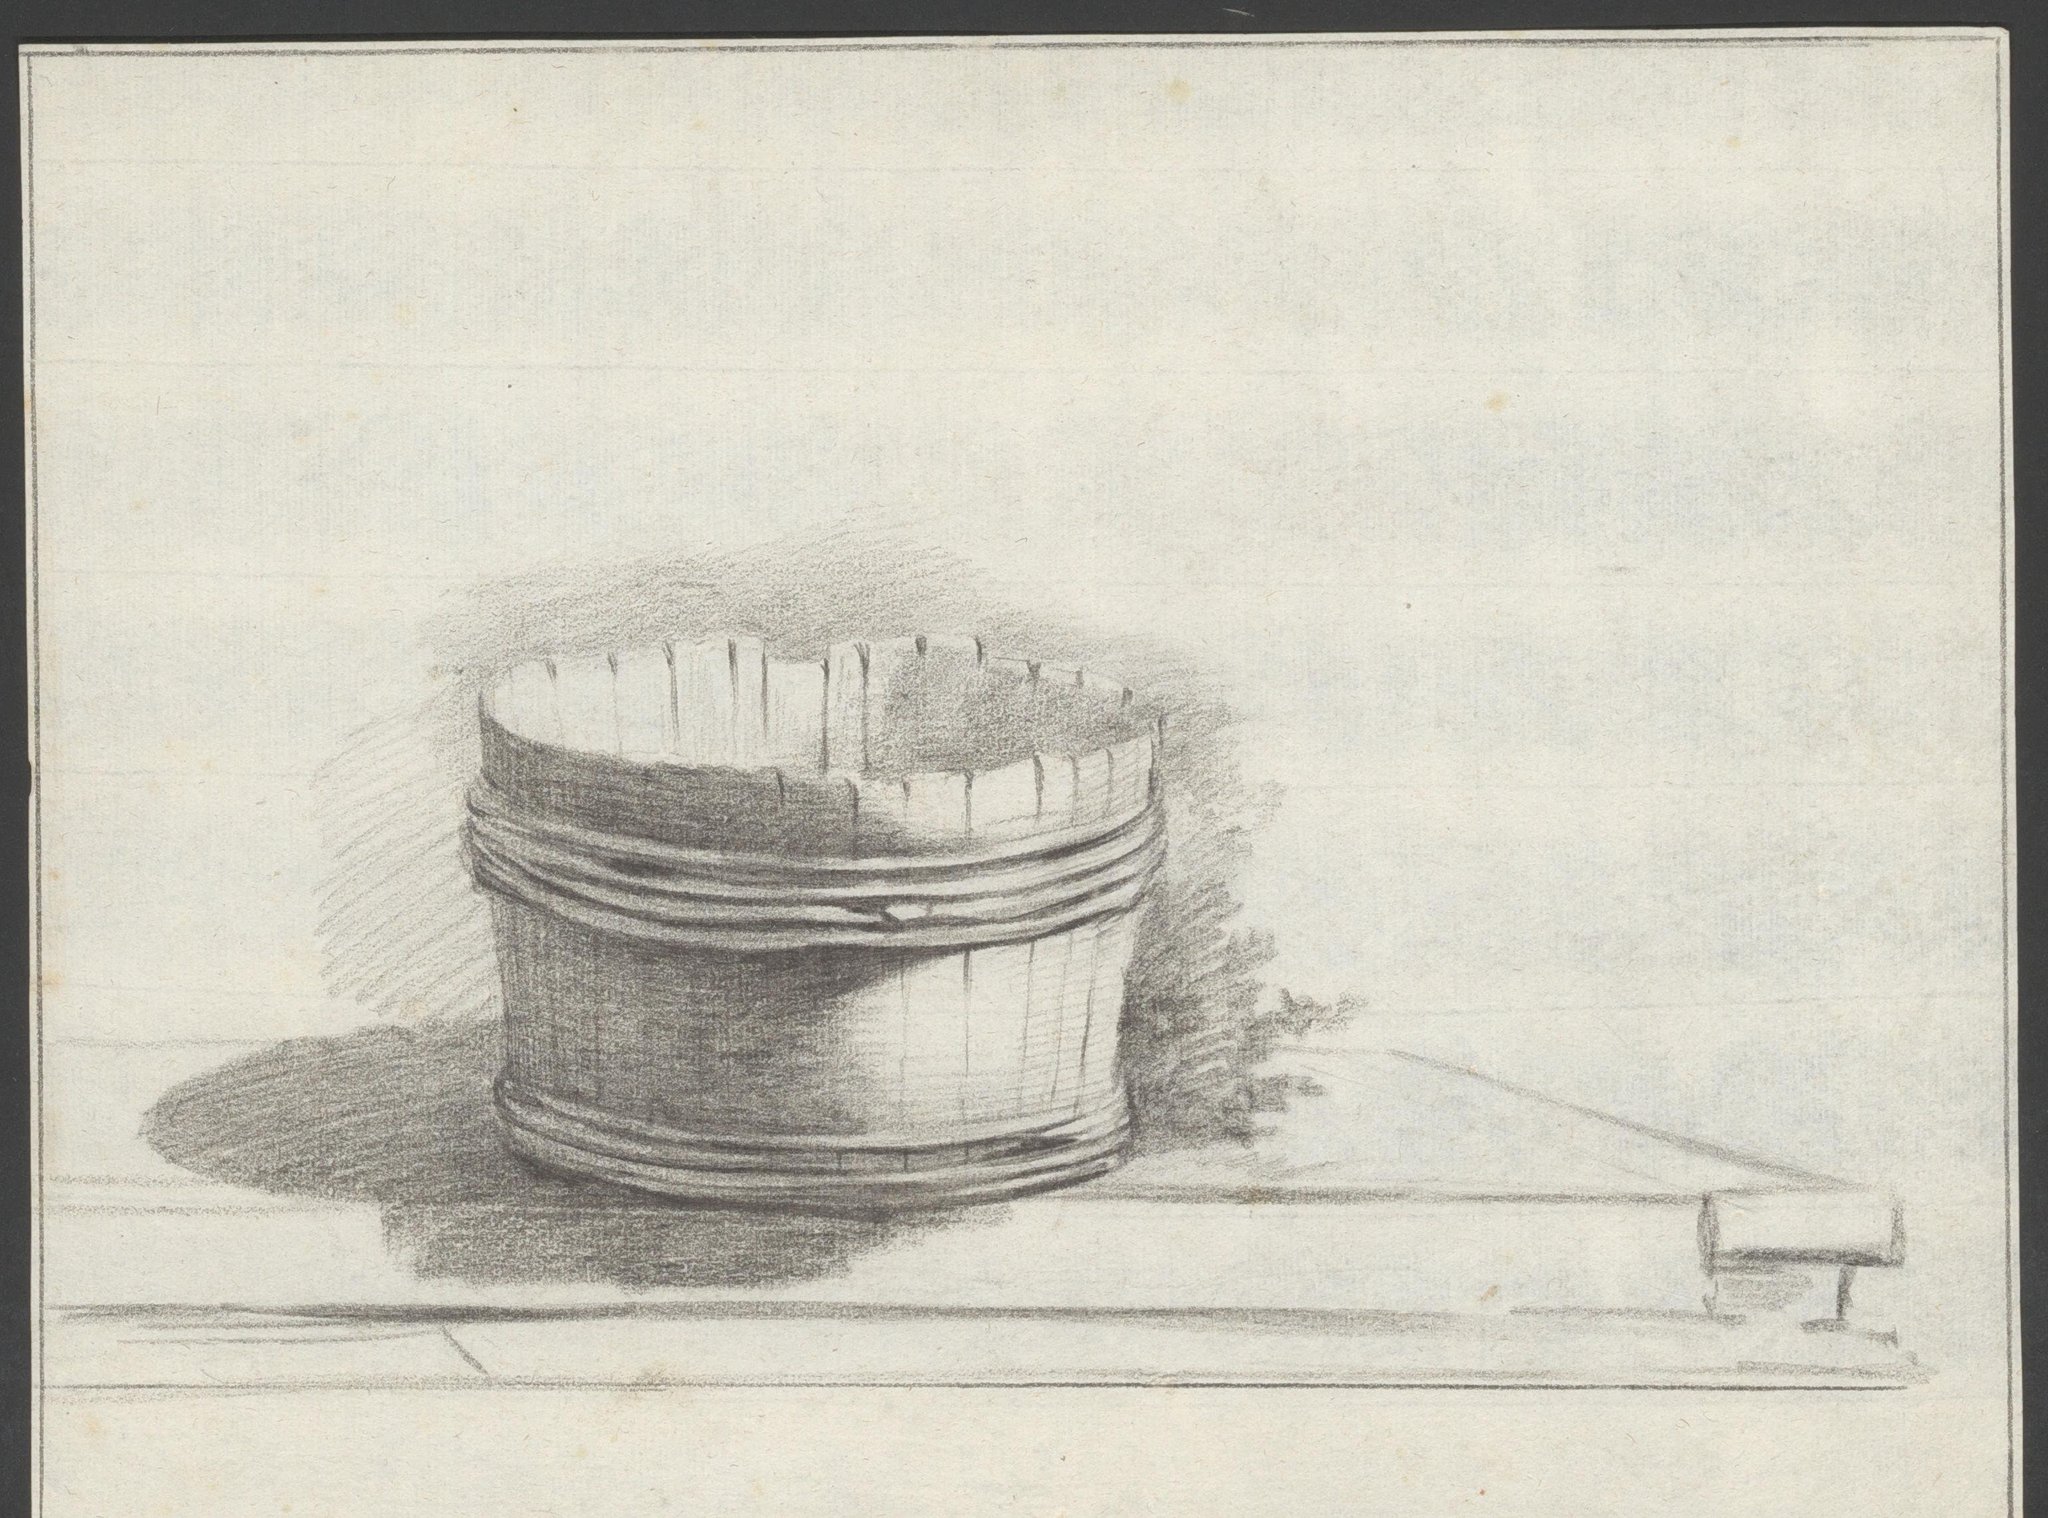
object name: drawing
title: Houten tobbe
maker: Anonymous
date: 1800-1899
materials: chalk, paper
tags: bath-tub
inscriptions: collector's mark: Lugt 1641, stamp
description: Onderwerpsrubrieken binnen de Atlas Zeden en Gewoonten: Schoone kunsten, Schilderkunst, Tekeningen.